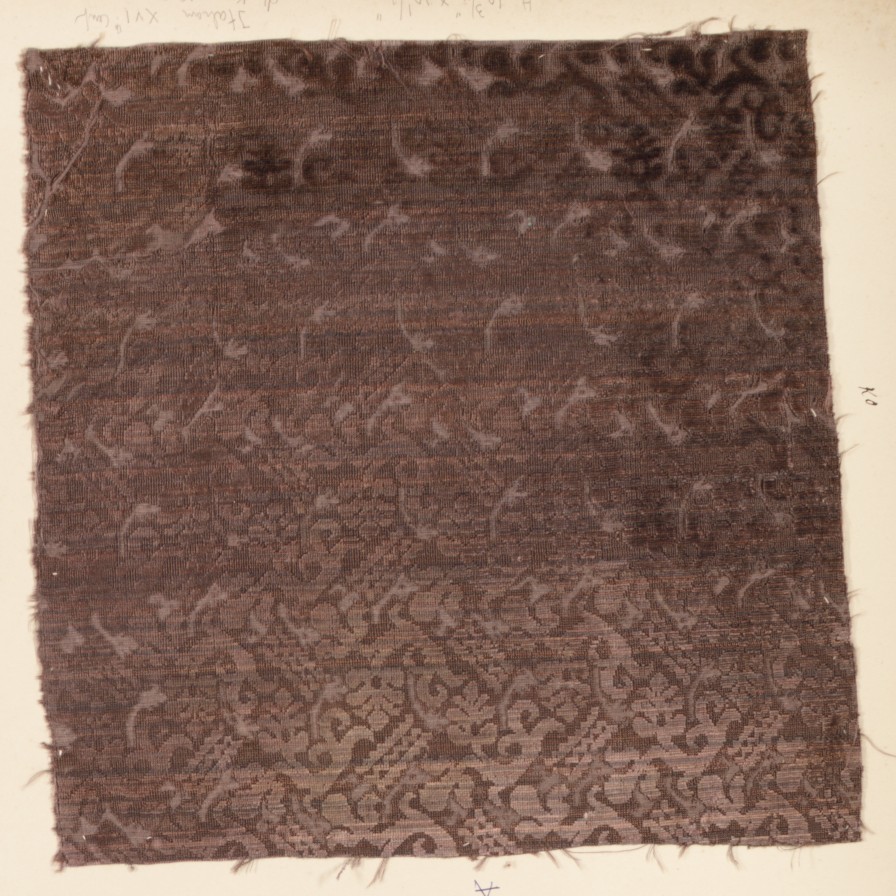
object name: fragment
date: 1501-1600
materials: silk